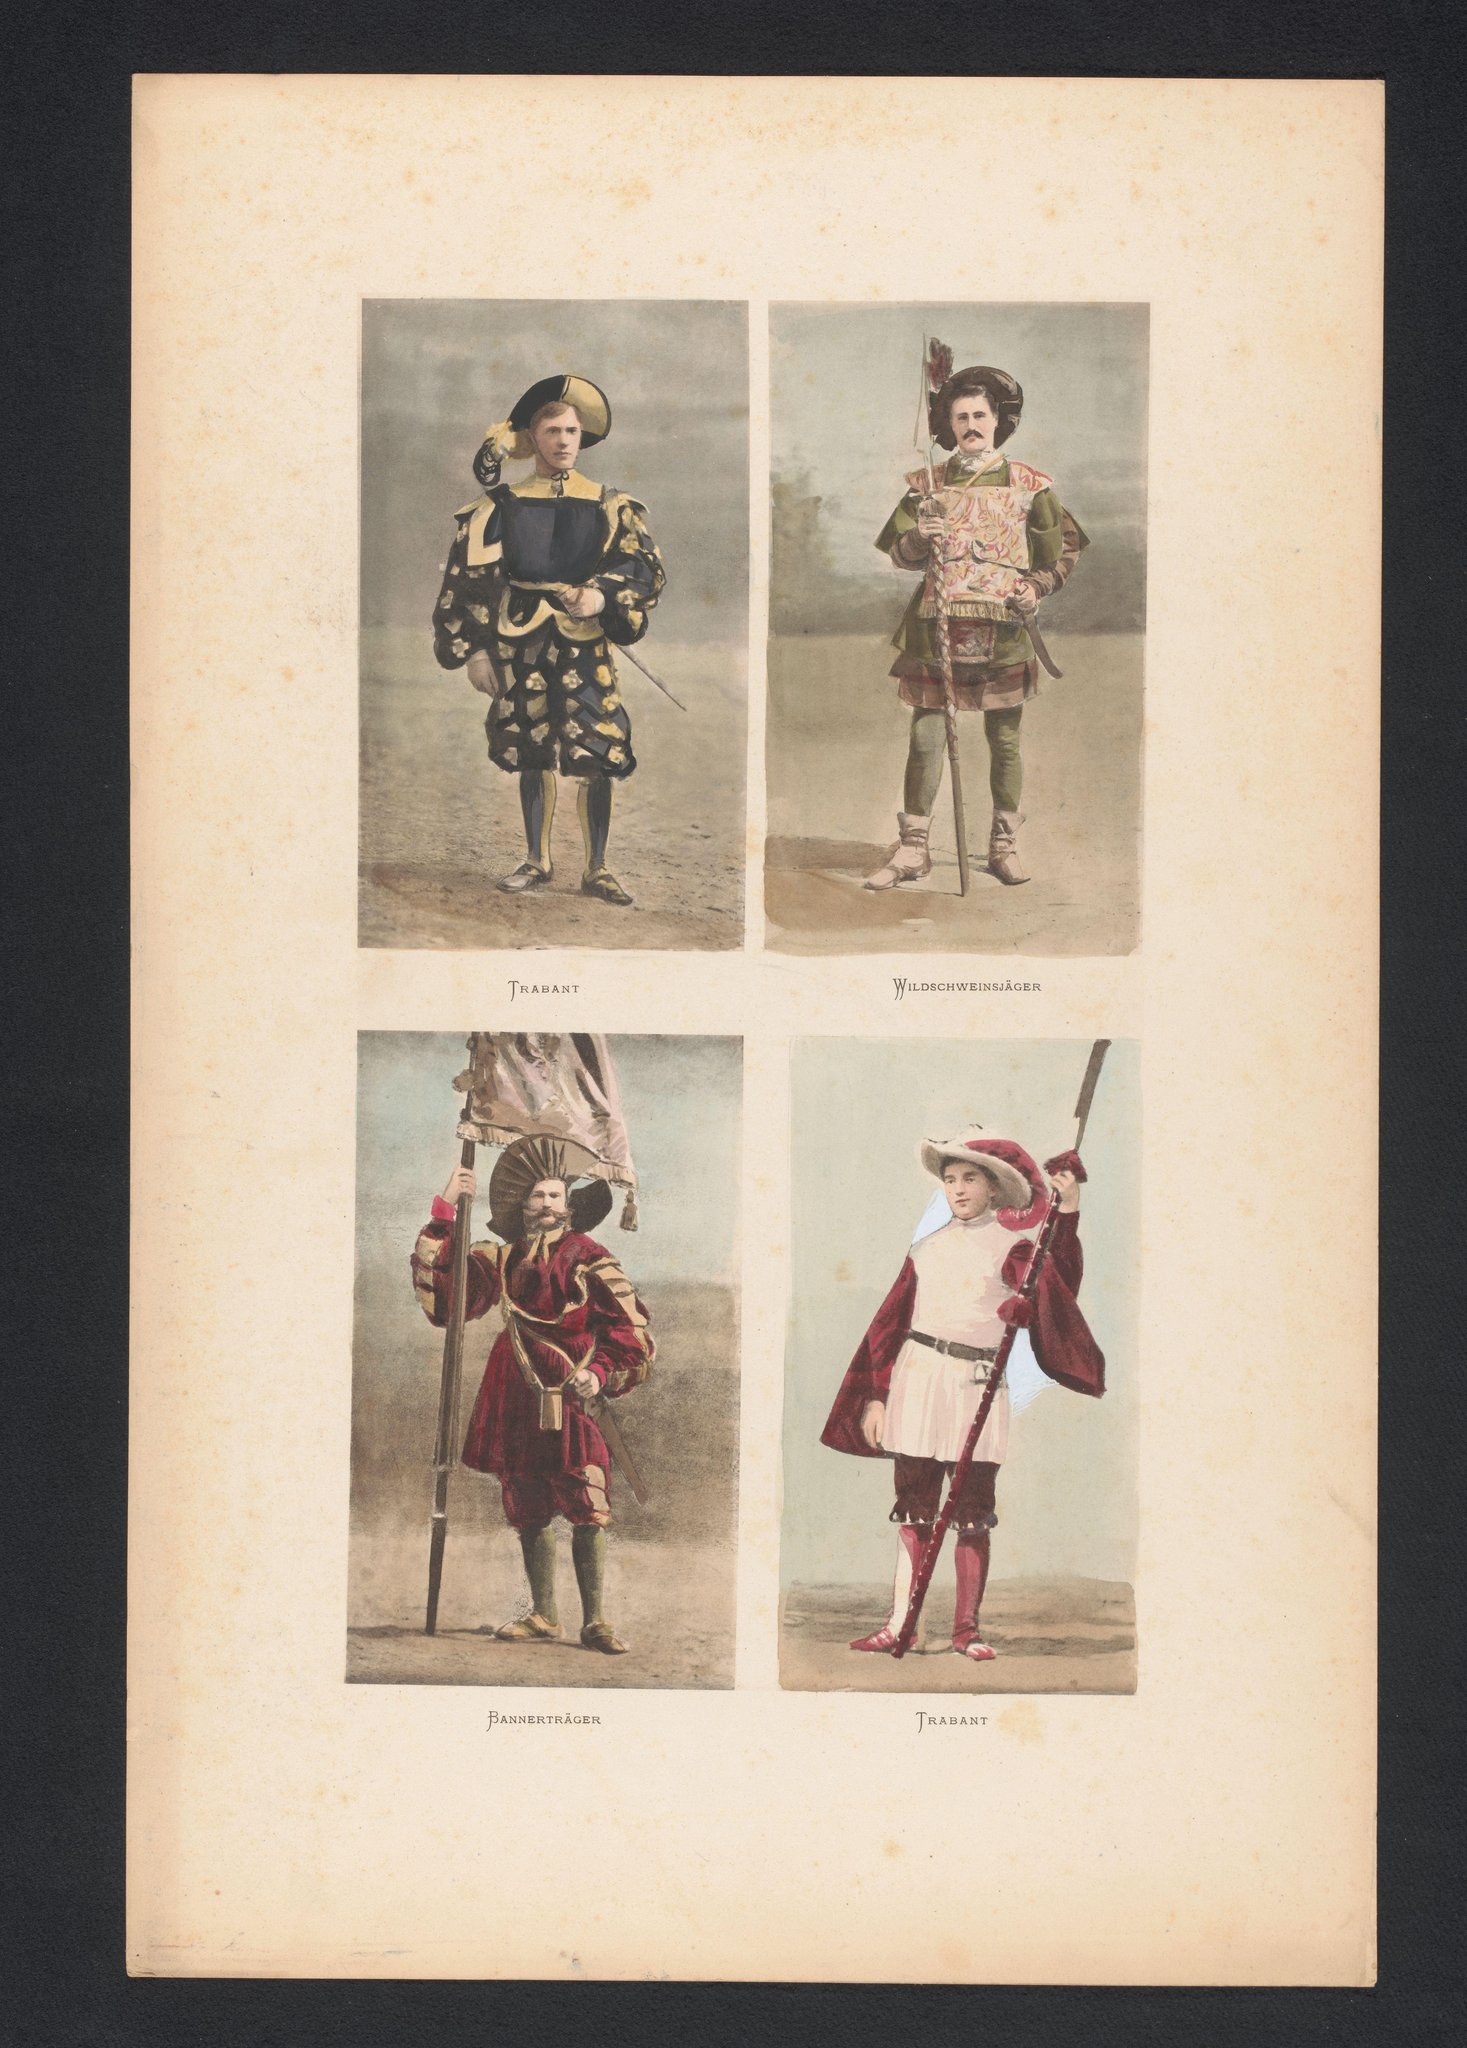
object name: photomechanical print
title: Vier afbeeldingen van mannen in kostuum, afgebeeld twee trawanten, een wild zwijn jager en een vaandeldrager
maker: Anonymous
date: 1876-1881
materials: paper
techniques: photograph, hand coloring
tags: stage costume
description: Deze prenten maken deel uit van een omslag met 86 prenten op 78 bladen en 11 tekstbladen.